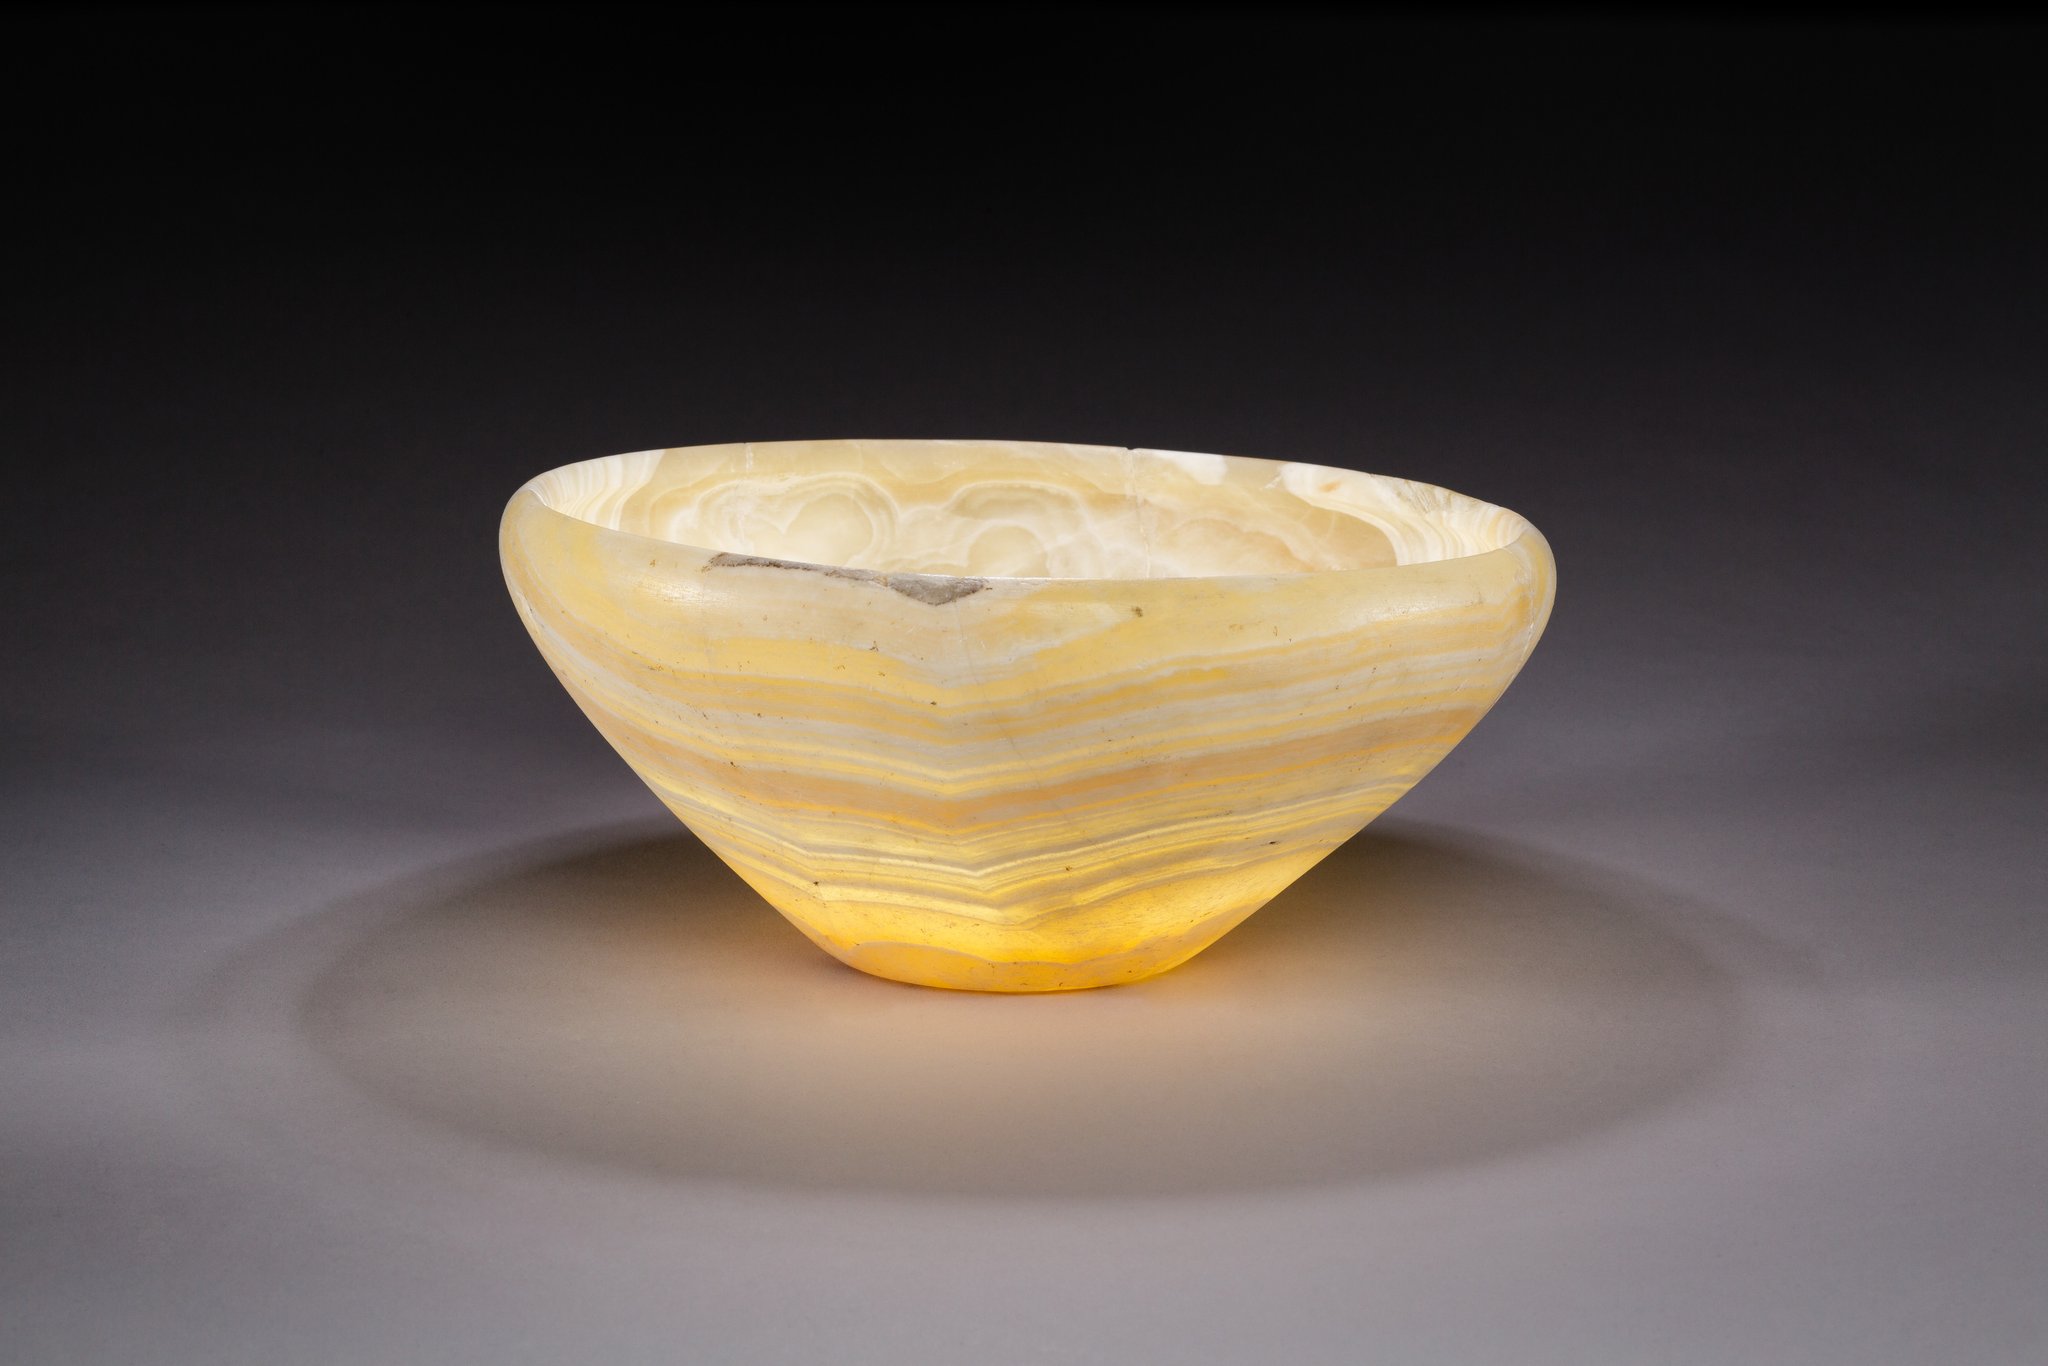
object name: bowl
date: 2750-2649 BCE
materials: stone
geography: egypt